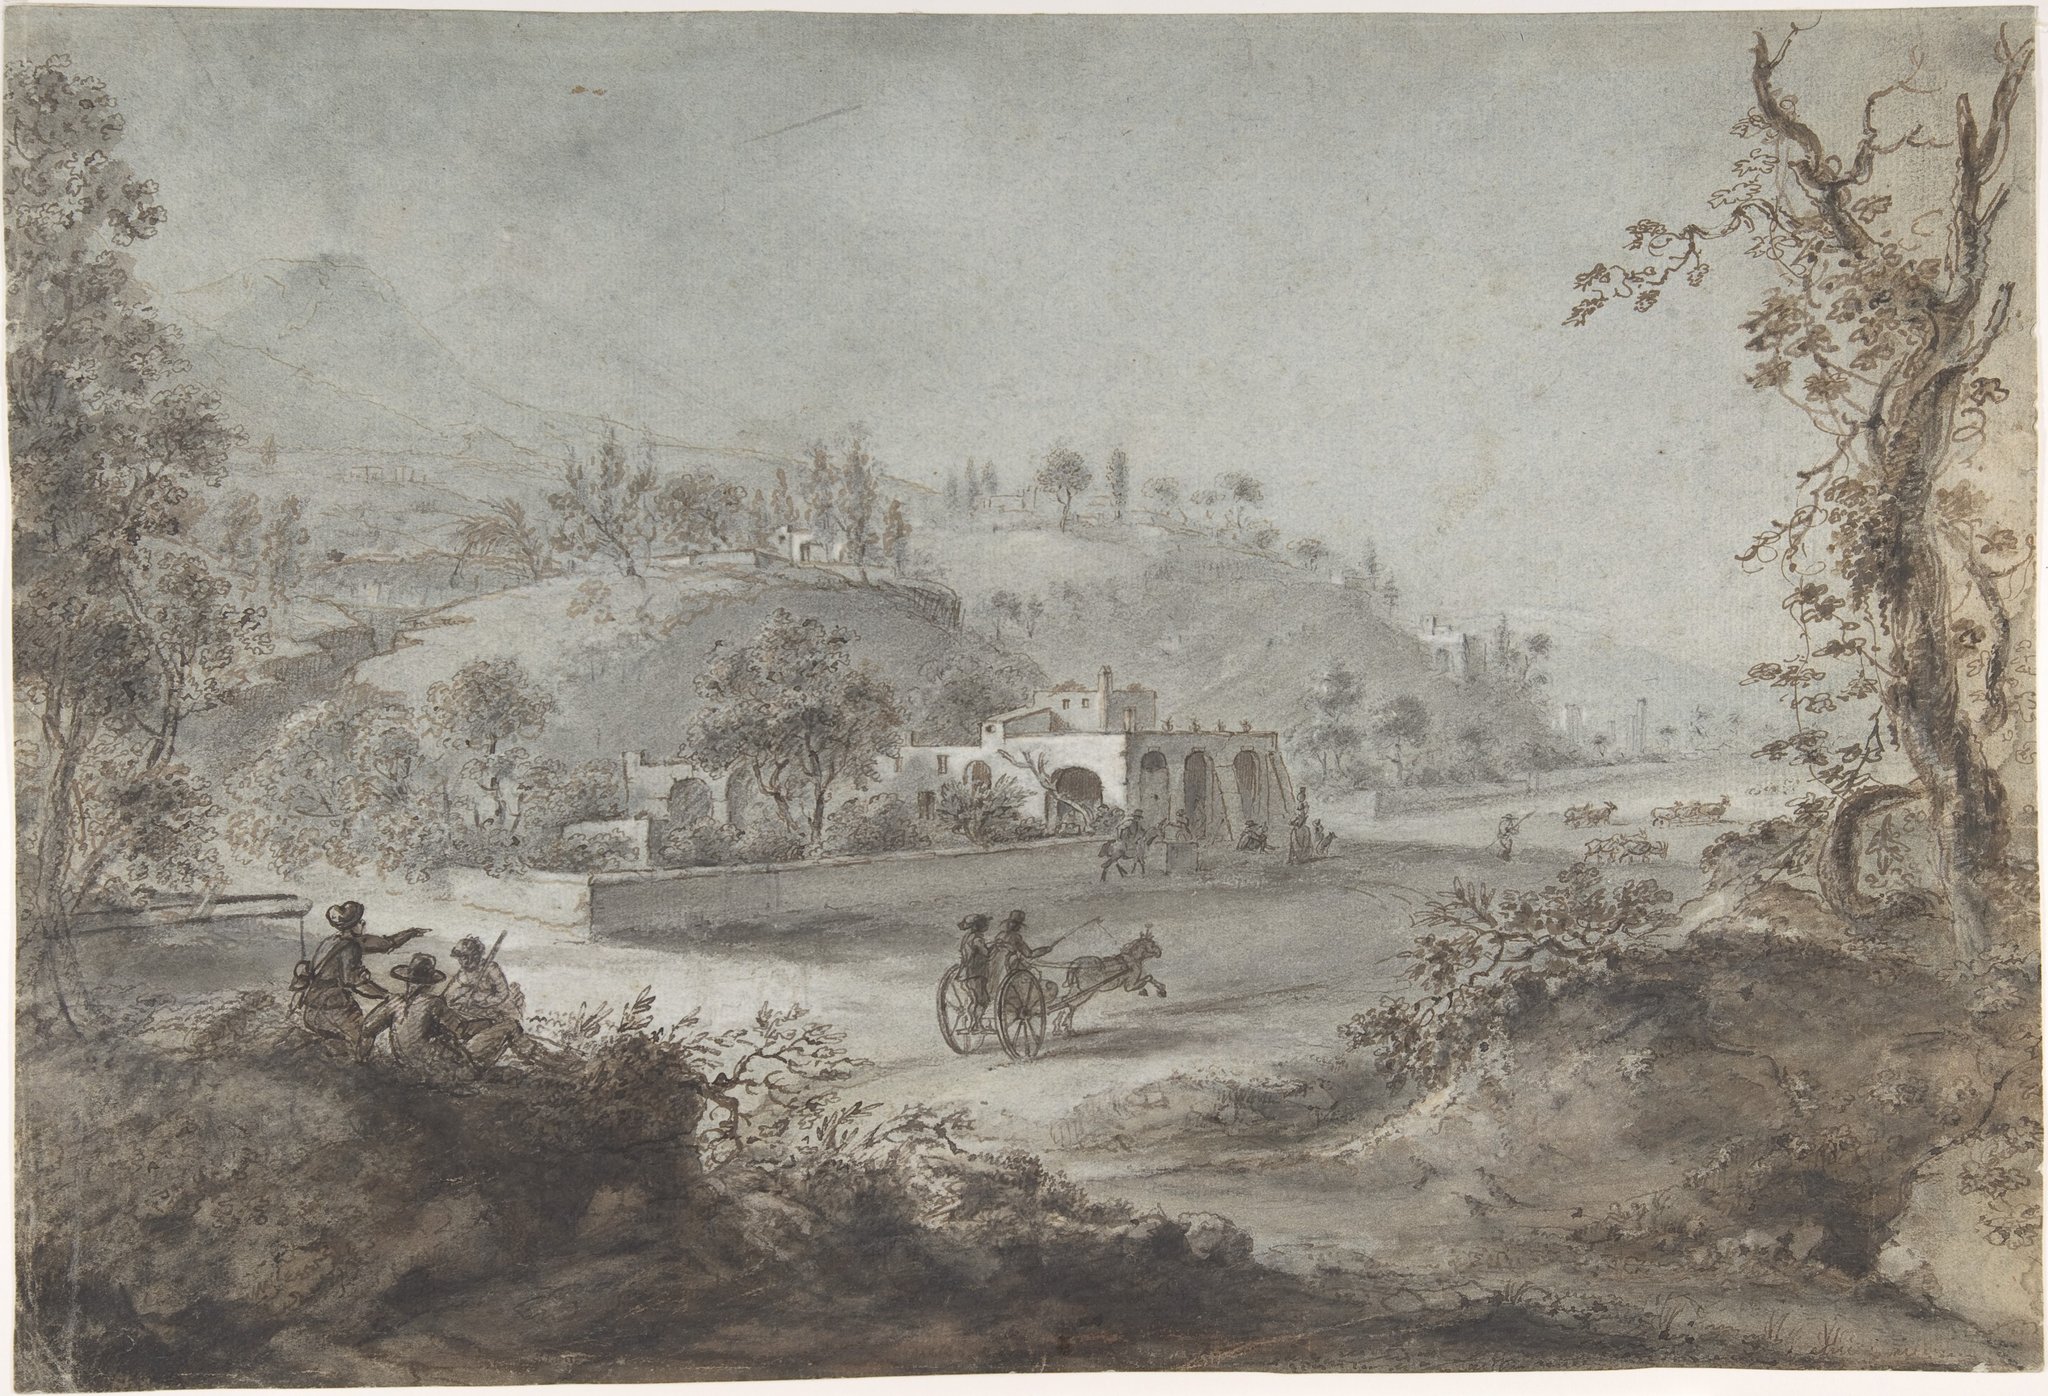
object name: drawing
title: Landscape Prospect with a Buggy and a Herd of Goats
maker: giuseppe zocchi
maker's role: artist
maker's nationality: italian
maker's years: 1711-1767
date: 1711-1767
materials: chalk, charcoal, ink, paper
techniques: brush, highlighting, pen, stumping, wash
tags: buildings,goats,horses,landscapes,trees